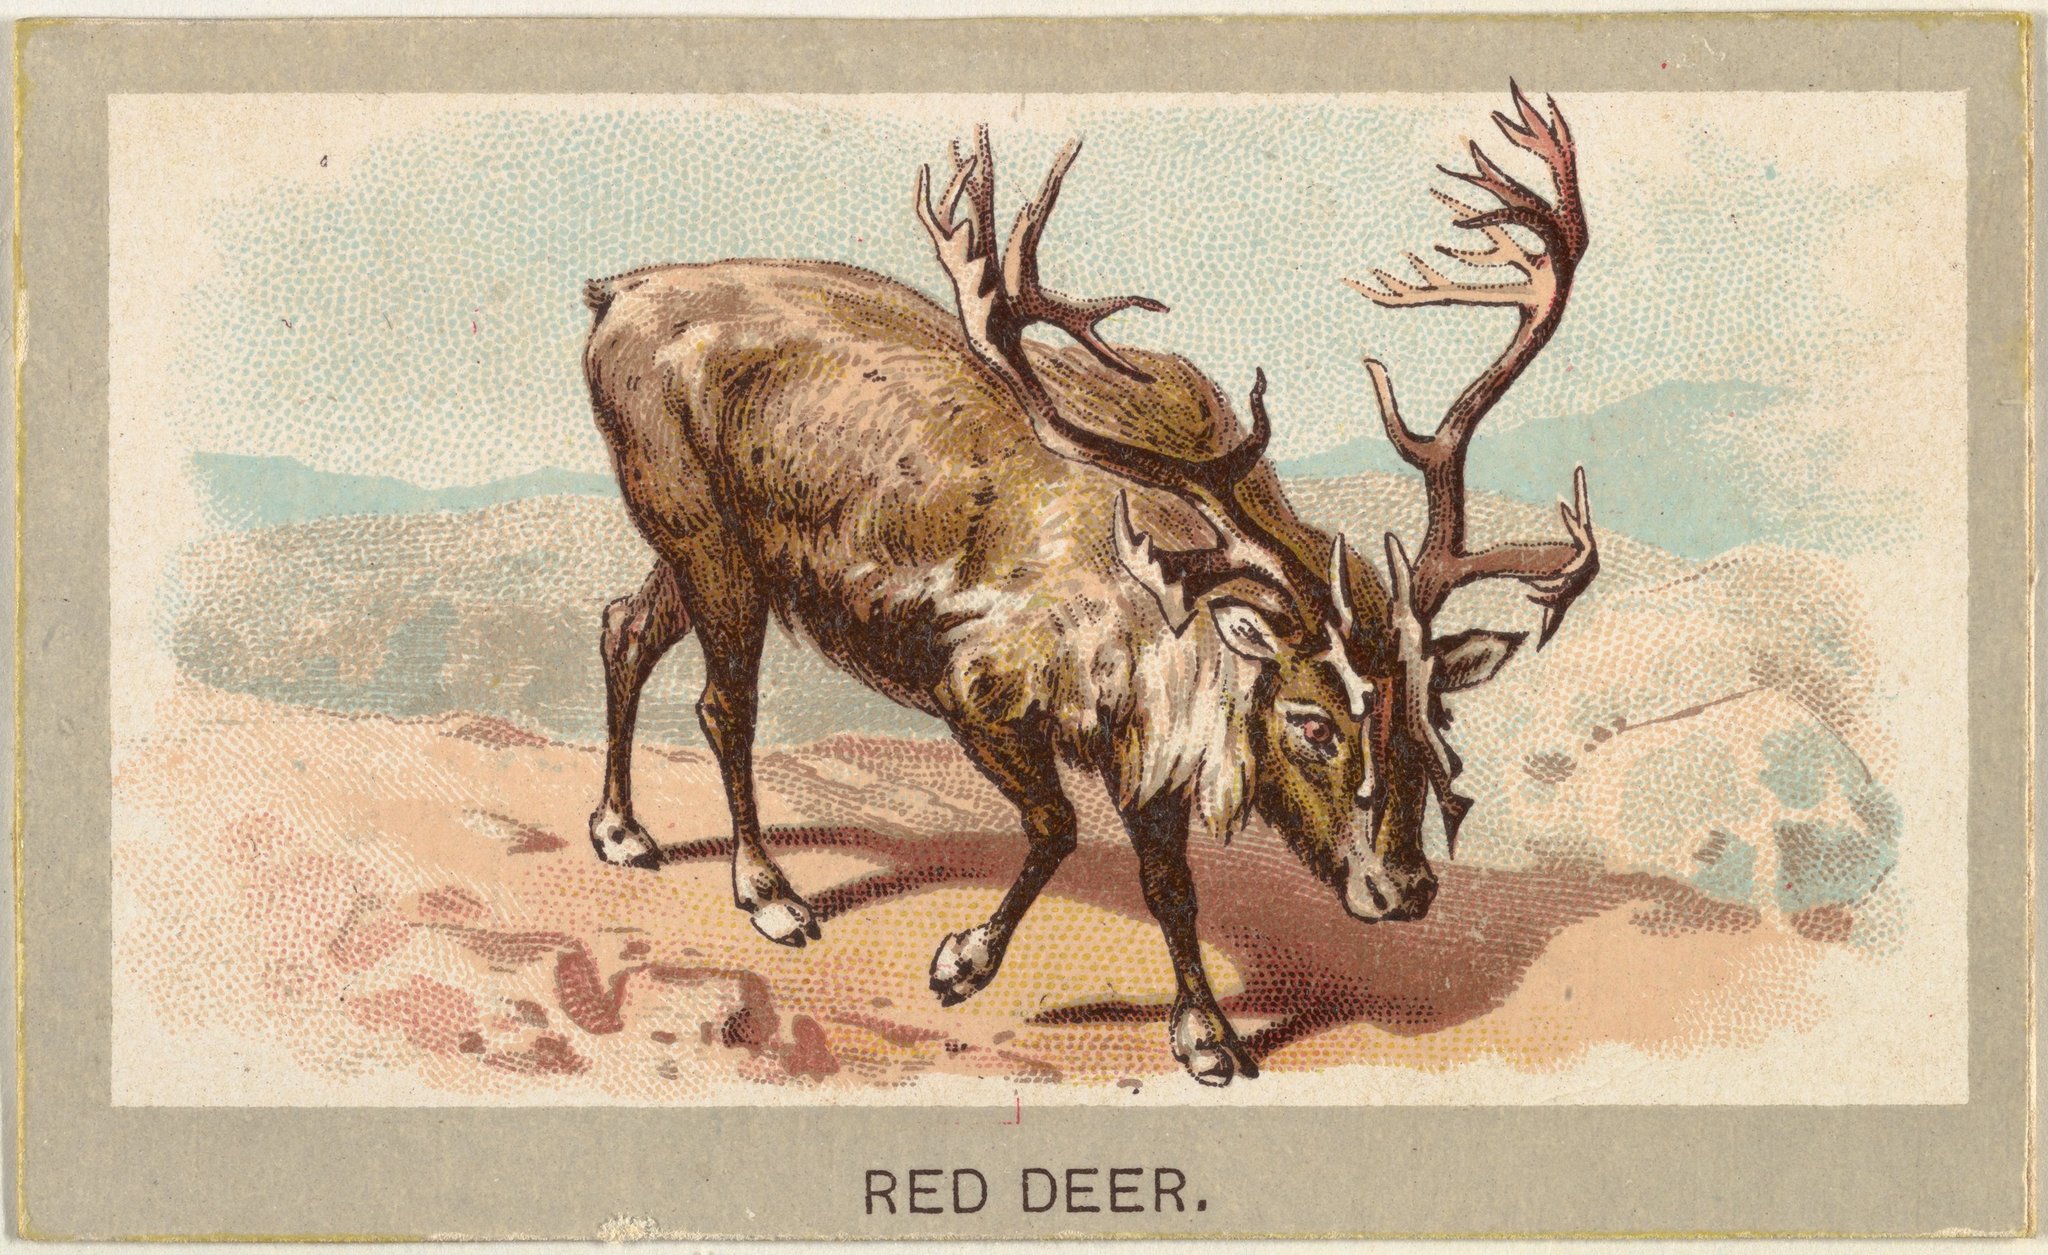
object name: print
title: Red Deer, from the Animals of the World series (T180), issued by Abdul Cigarettes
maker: abdul cigarettes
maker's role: publisher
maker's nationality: american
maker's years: 1881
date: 1881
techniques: color lithograph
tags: deer